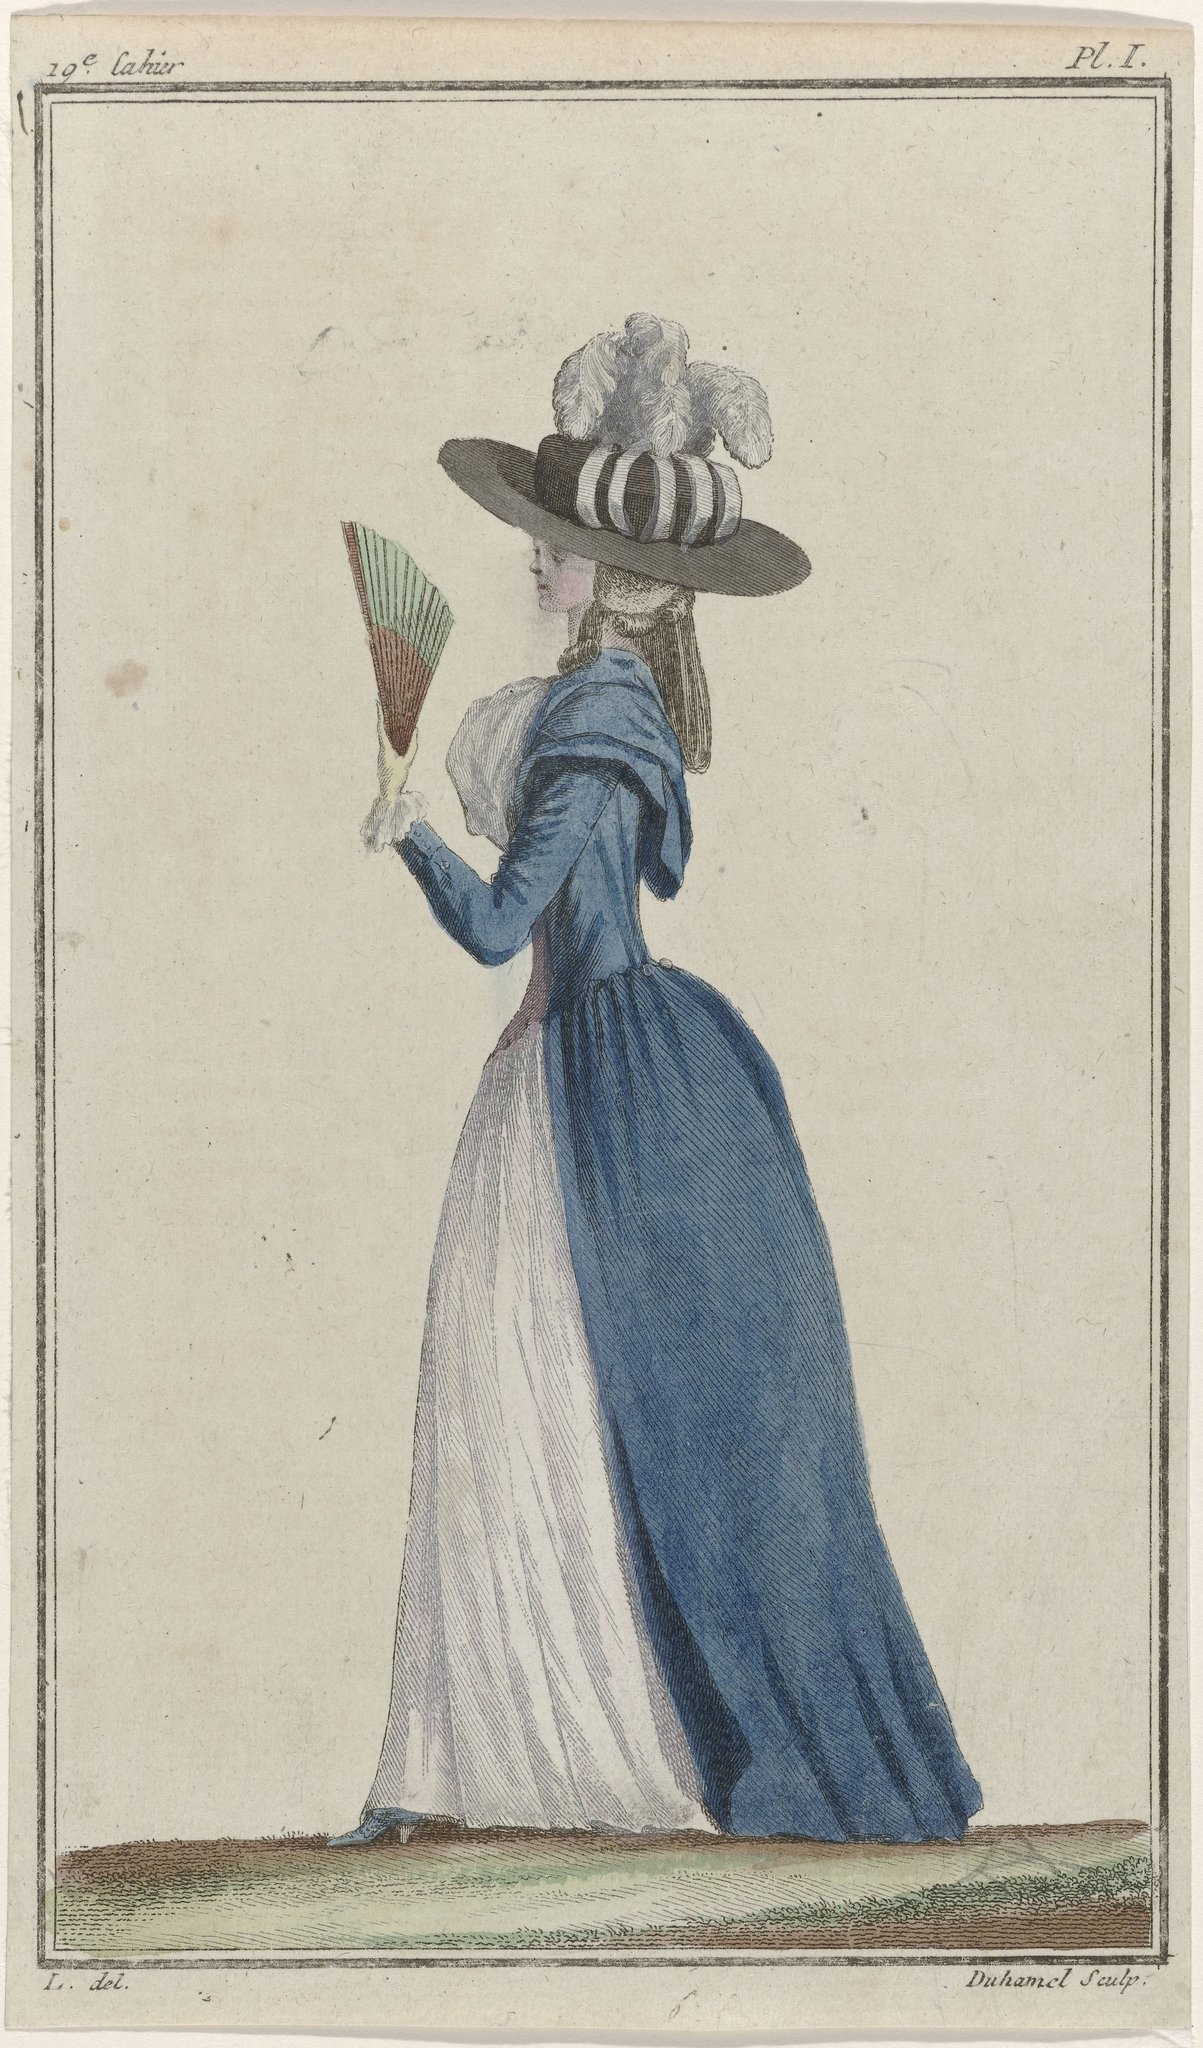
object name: fashion print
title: Cabinet des Modes ou les Modes Nouvelles, 15 août 1786, Pl. I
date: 1786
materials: paper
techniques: engraving, hand coloring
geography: paris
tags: clothing for the upper part of the body (+ women's clothes), dress, gown: redingote (+ women's clothes), head-gear (straw hat) (+ women's clothes), fashion plates, skirt (+ women's clothes), piece of clothing covering the breast or décolleté (fichu) (+ women's clothes)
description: Vrouw in blauwe redingote met drie schouderkragen en een rok van roze tafzijde. Om de hals een fichu. Accessoires: strohoed met brede rand en veren, handschoenen, vouwwaaier, schoenen met hakken. De prent maakt deel uit van het 19e Cahier uit Cabinet des Modes ou les Modes Nouvelles. De serie bestaat uit 72 modeprenten, uitgegeven door Buisson, Parijs, 15 november 1785 - 1 november 1786.